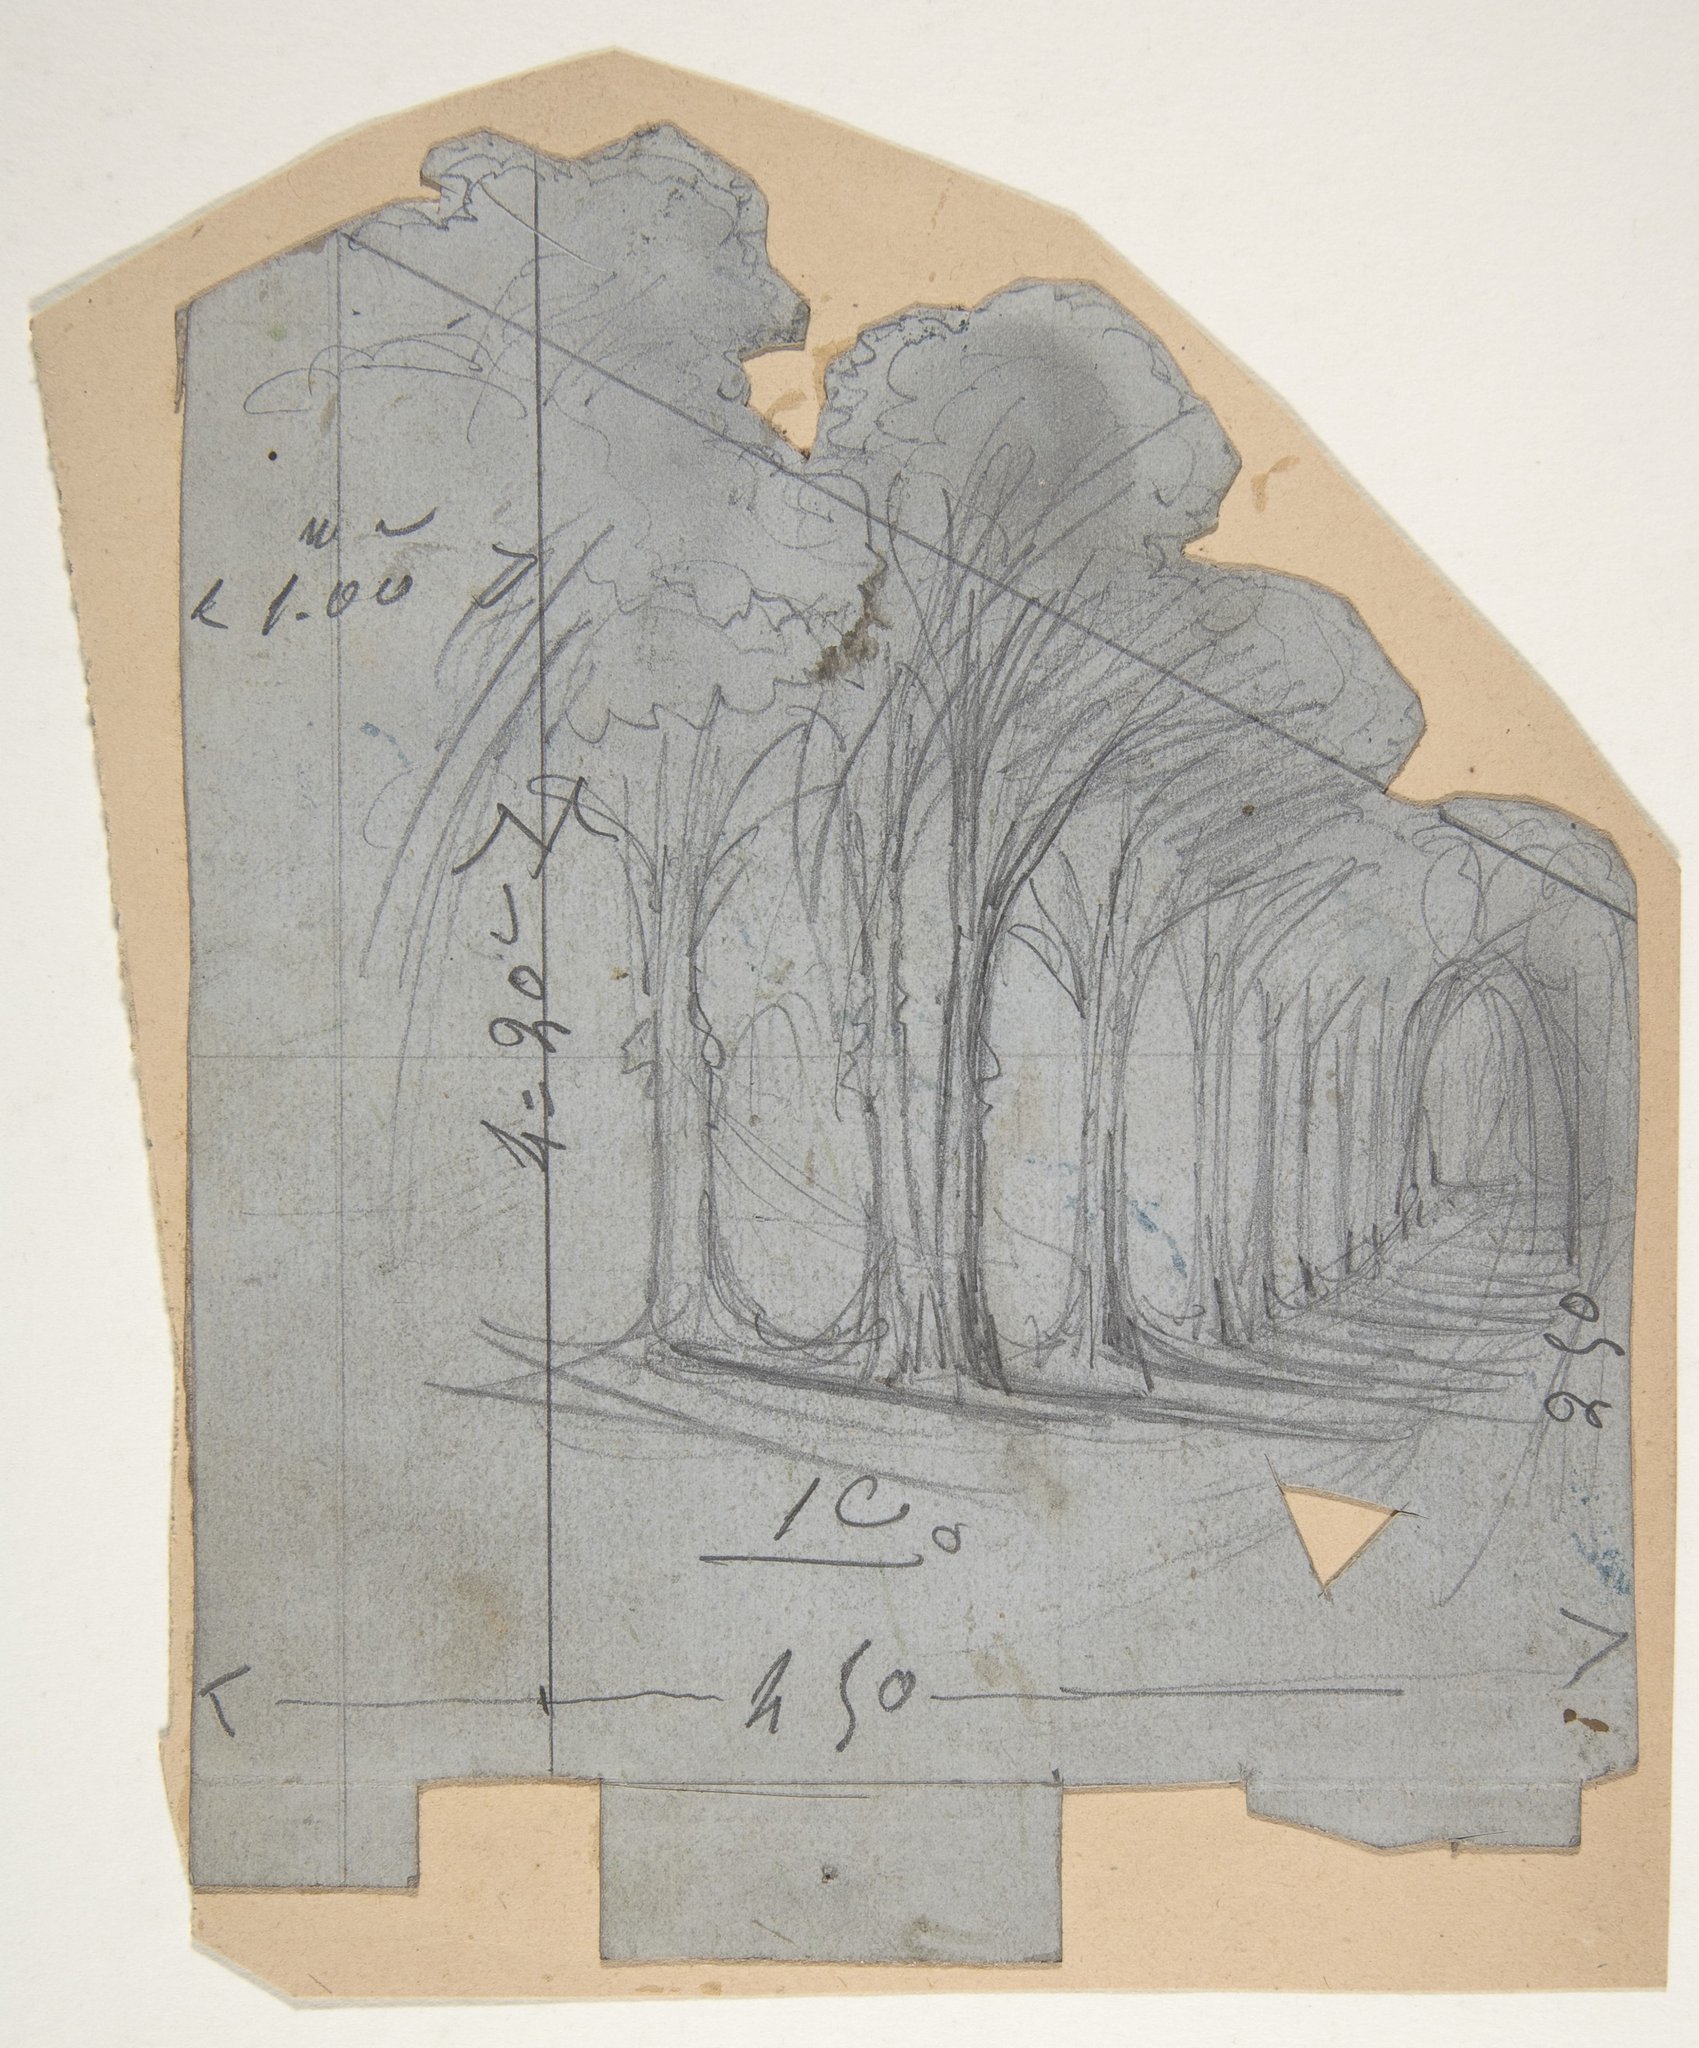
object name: drawing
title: Design for a Stage Set at the Opéra, Paris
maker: eugène cicéri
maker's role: artist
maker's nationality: french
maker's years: 1813-1890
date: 1830-1890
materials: graphite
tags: trees,stage design